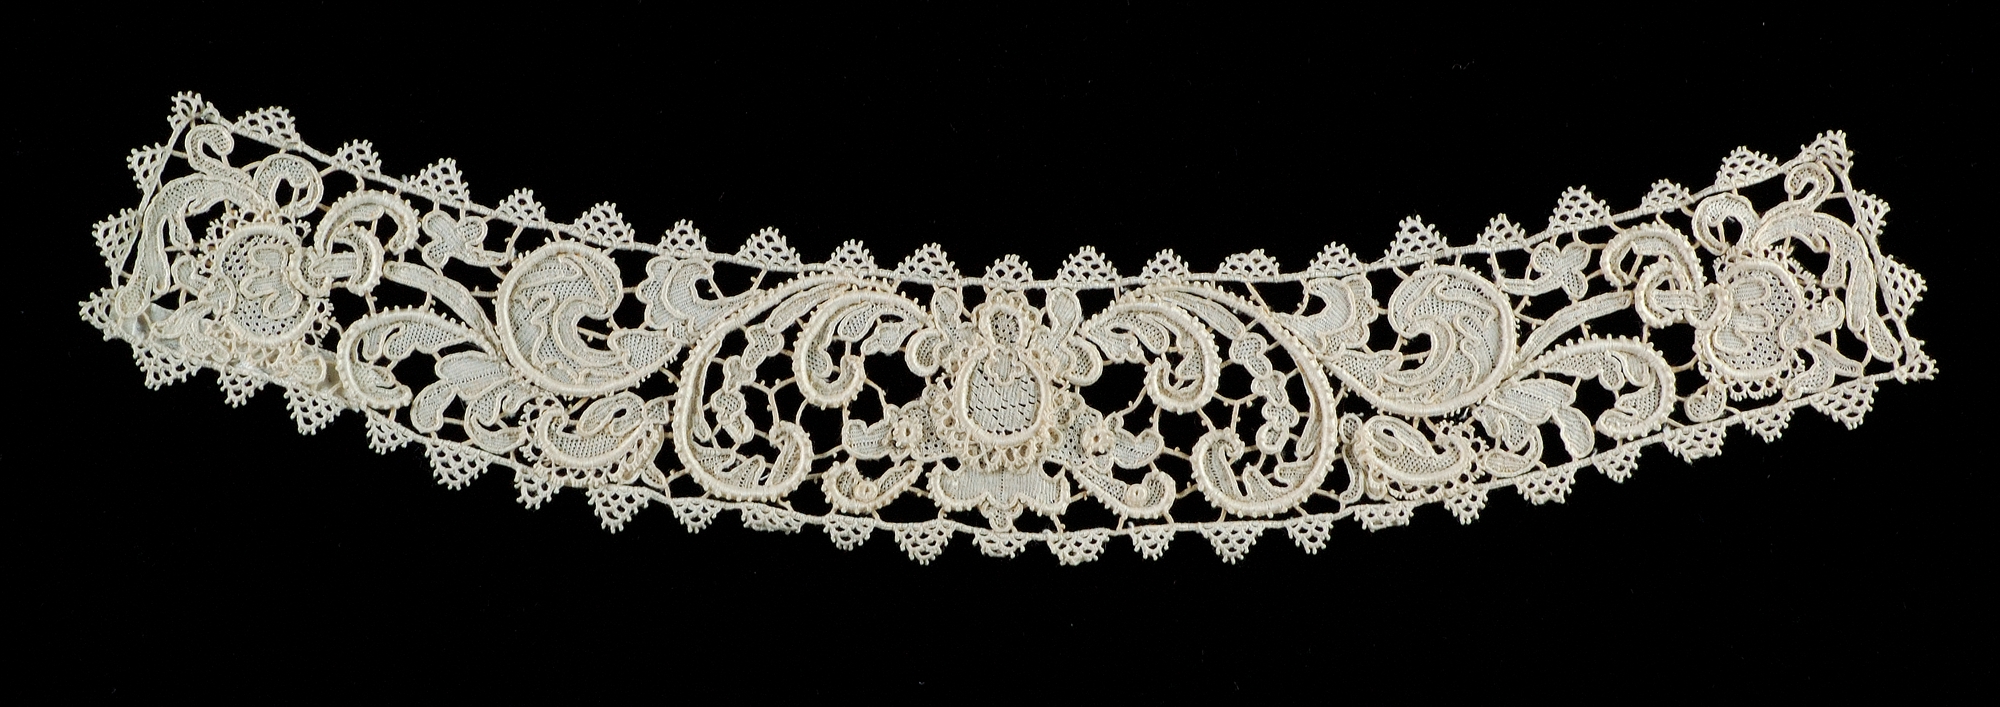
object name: collar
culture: italian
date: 1880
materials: linen